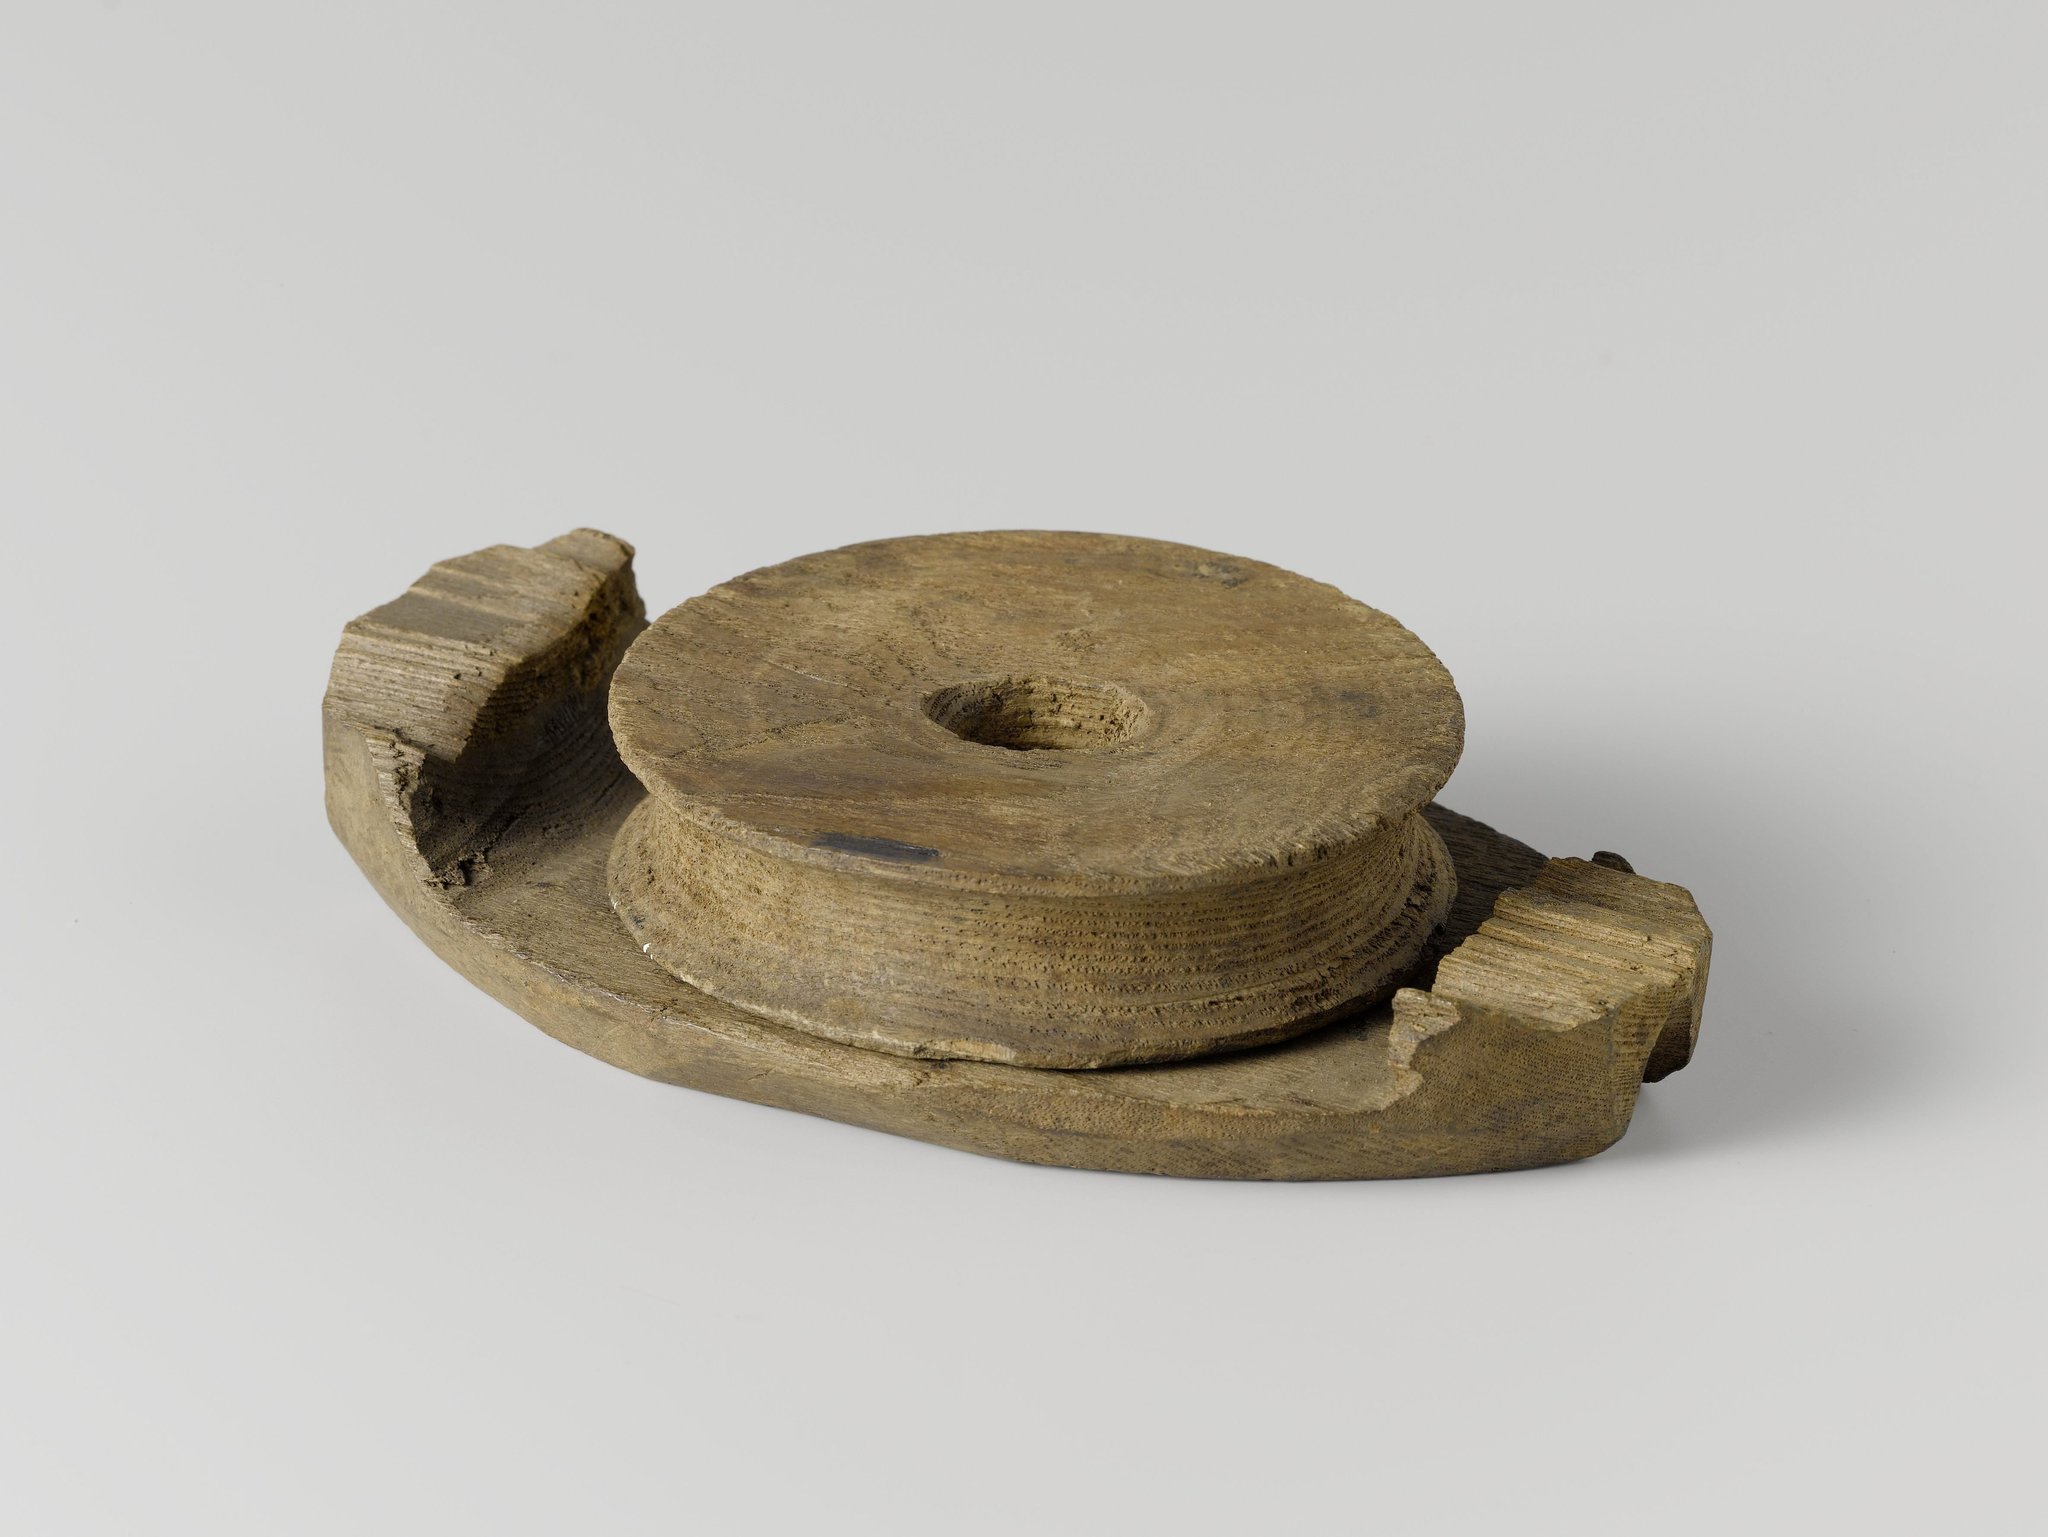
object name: eenschijfsblok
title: Eénschijfsblok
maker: Anonymous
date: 1590-1596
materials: wood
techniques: cutting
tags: willem barendsz., amsterdam, jacob van heemskerck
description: Scheepsonderdeel, eénschijfsblok, helft van het huis aanwezig, met schijf.